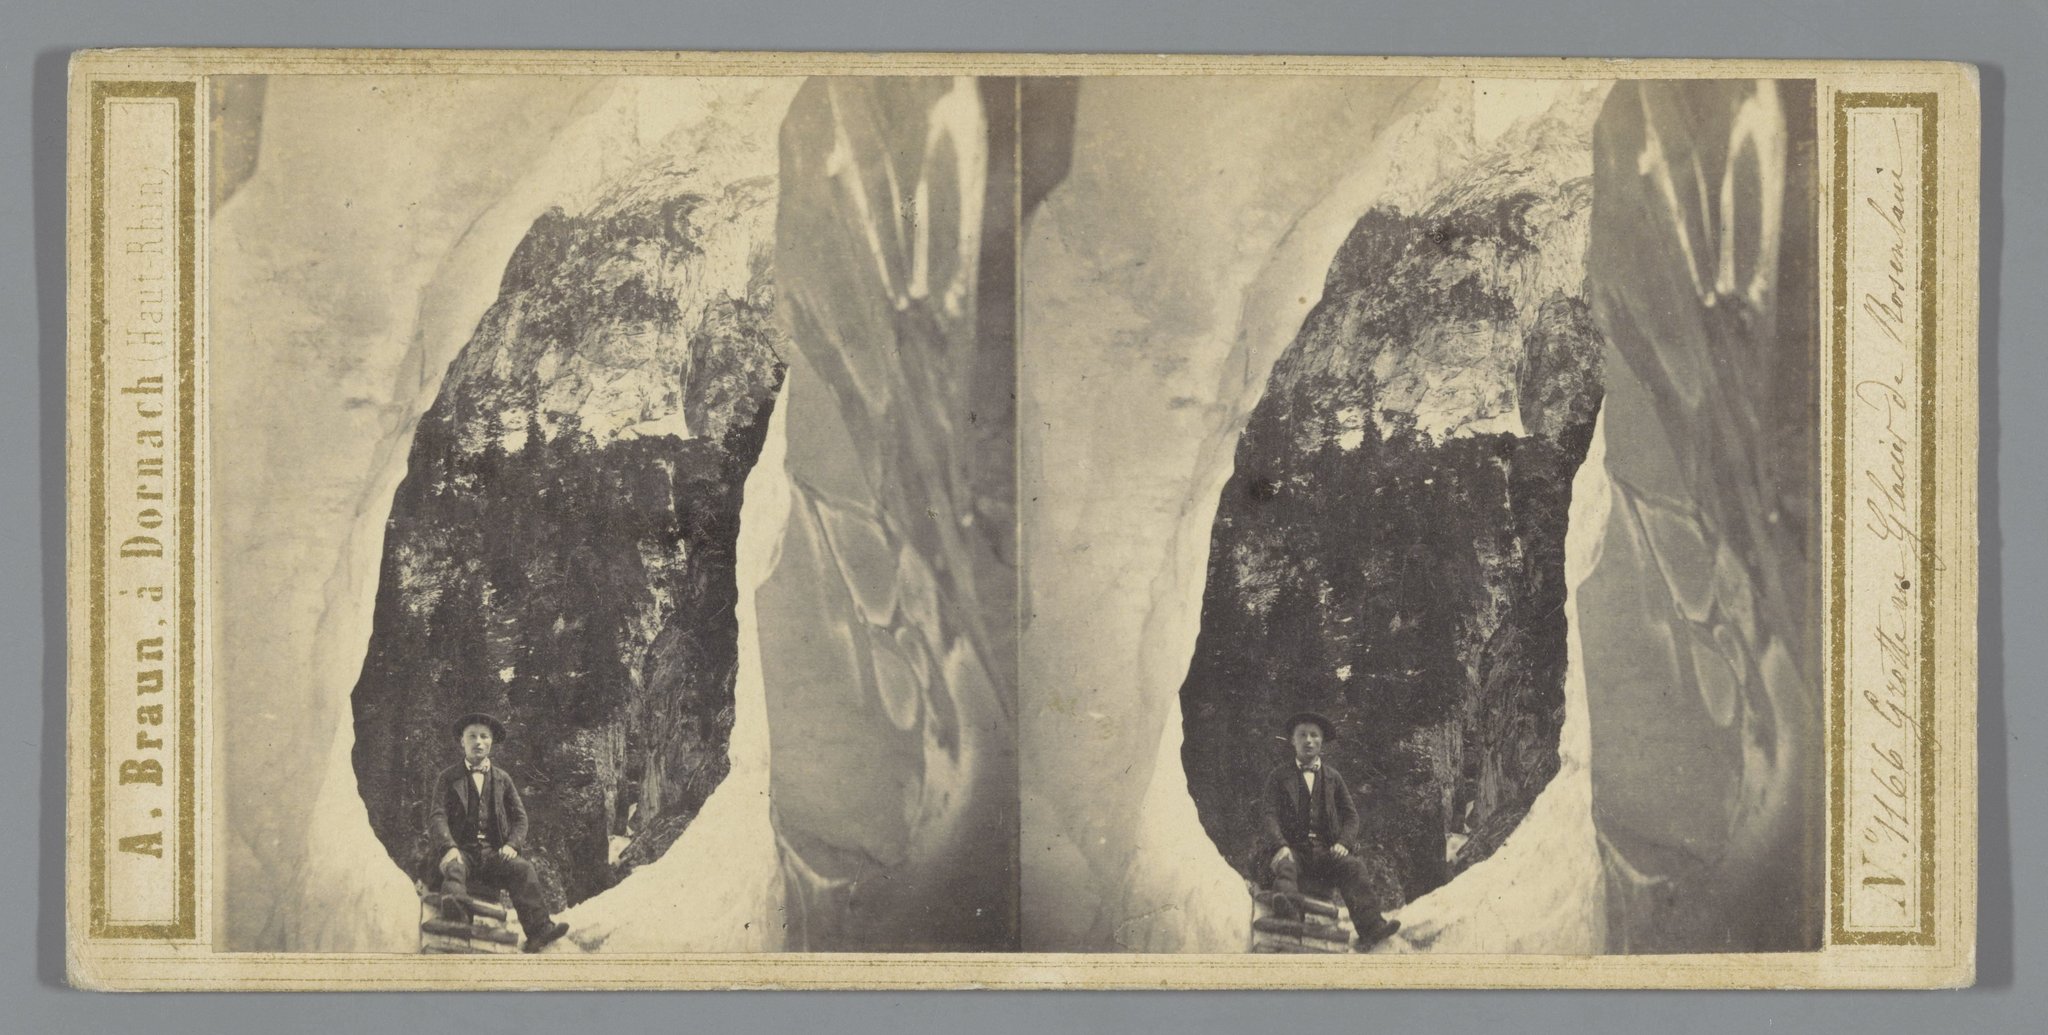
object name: stereograph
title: Grotte au Glacier de Rosenlaui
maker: Anonymous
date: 1860-1866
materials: cardboard, paper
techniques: albumen print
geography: dornach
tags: cave, grotto, glacier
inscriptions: number: ‘No. 1166’, inscription: ‘/W11’